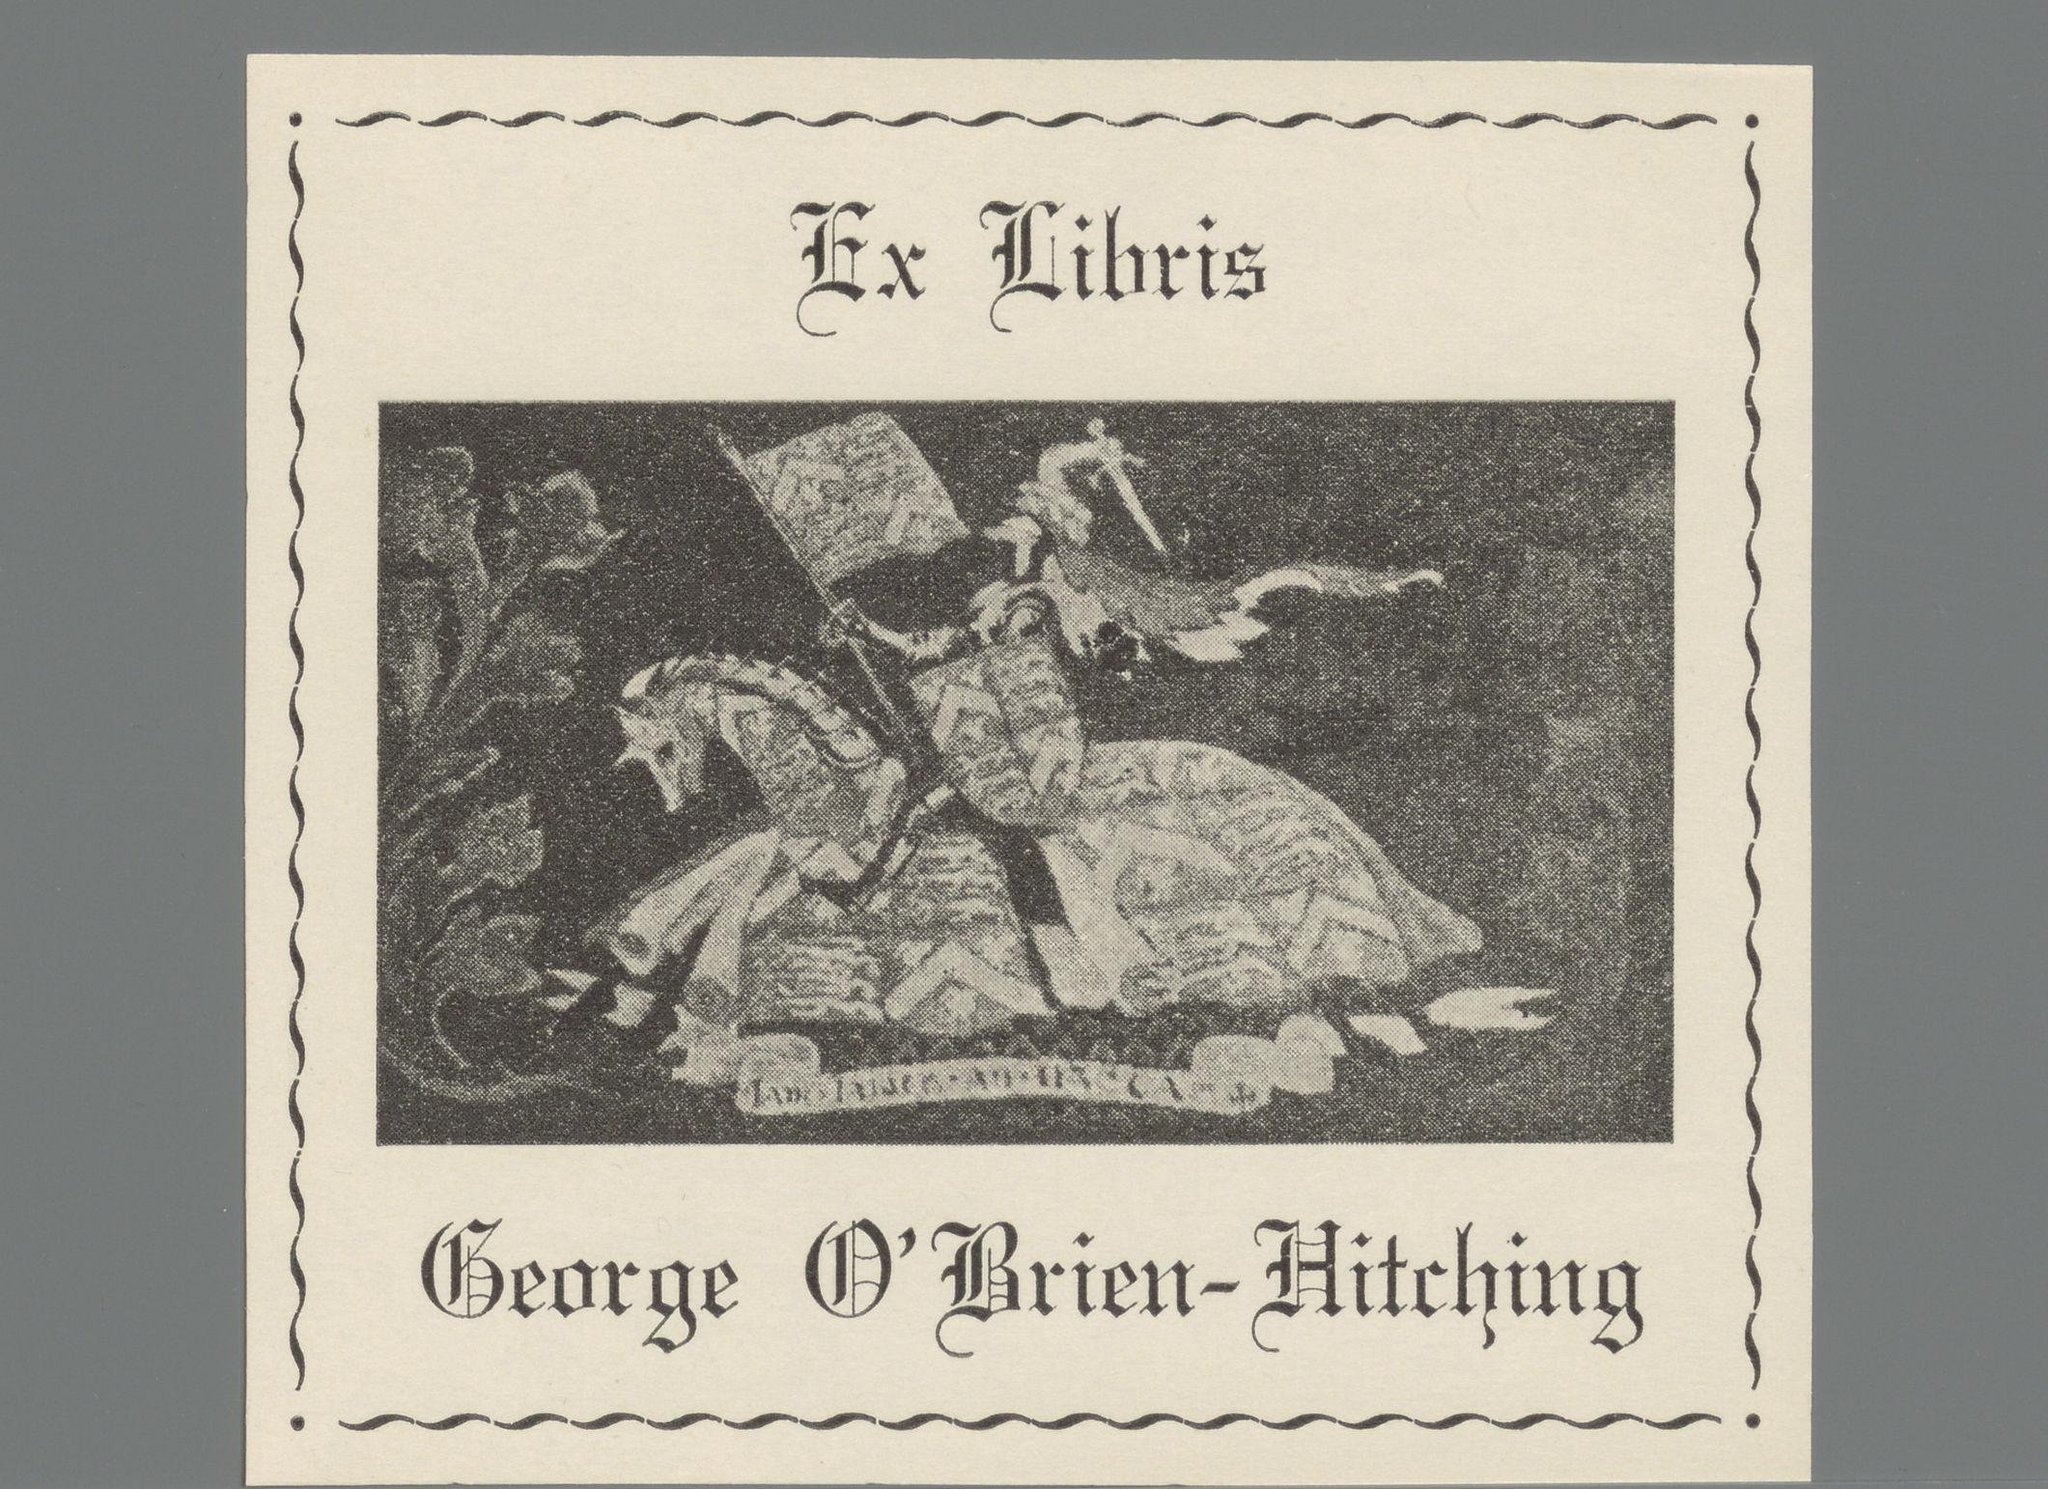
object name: photomechanical print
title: Ex libris van George O'Brien-Hitching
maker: Anonymous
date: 1900-1959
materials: paper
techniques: autotype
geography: england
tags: horse, knight, armorial bearing, heraldry